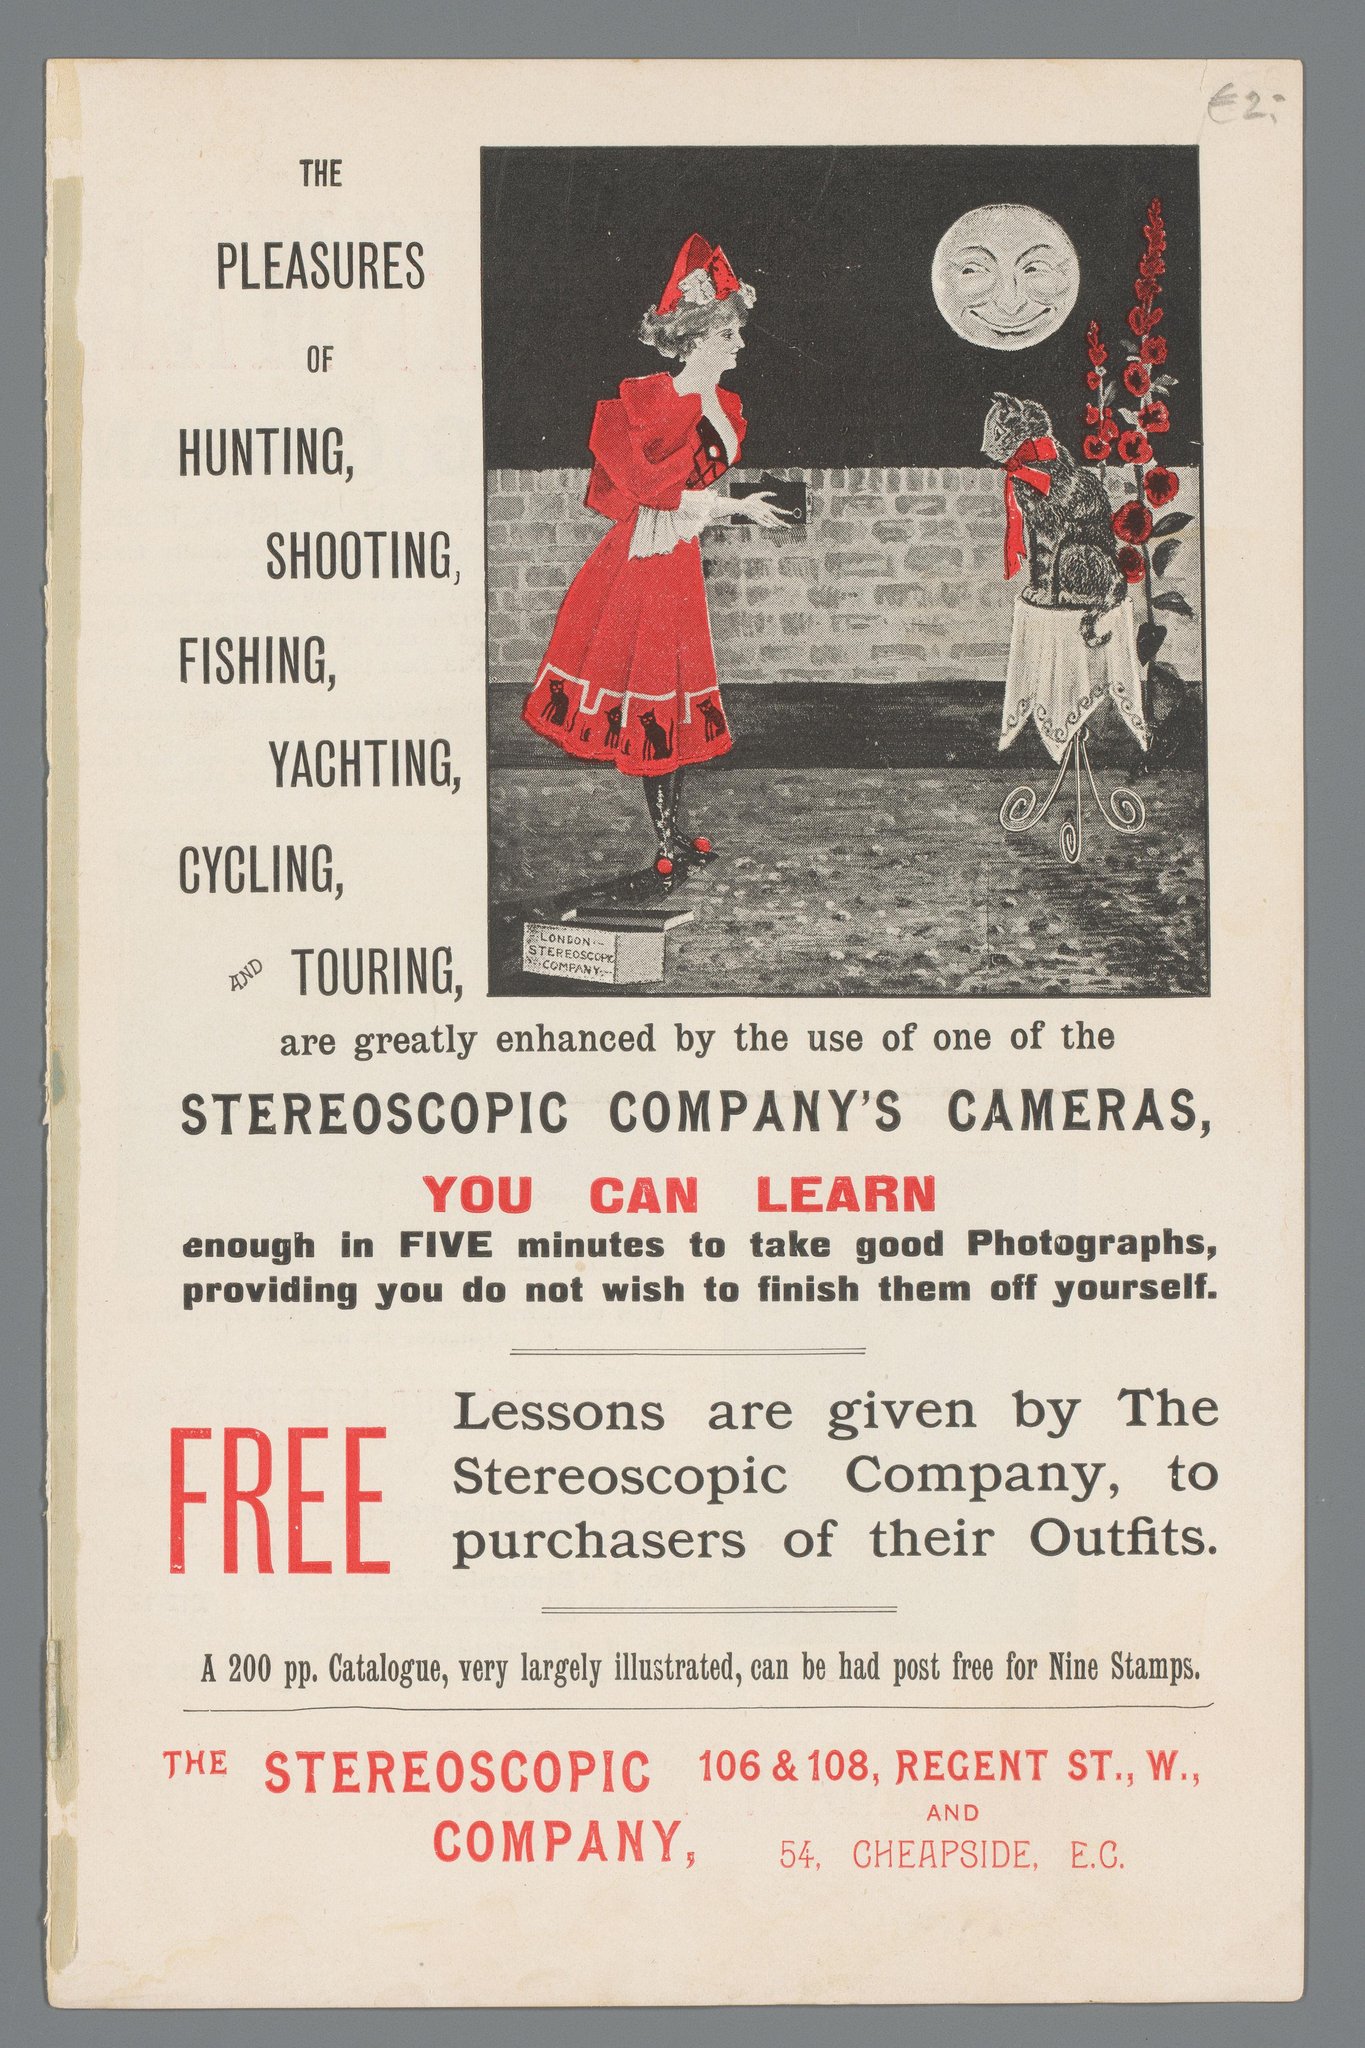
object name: document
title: Folder van de London Stereoscopic Company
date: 1881-1922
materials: paper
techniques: letterpress printing, lithograph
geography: london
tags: advertising, london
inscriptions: inscription: ‘THE/ PLEASURES/ OF/ HUNTING,/ SHOOTING,/ FISHING,/ YACHTING,/ CYCLING,/ AND TOURING,/ are greatly enhanced by the use of one of the/ STEREOSCOPIC COMPANY'S CAMERAS,/ YOU CAN LEARN/ enough in FIVE minutes to take good Photographs,/ providing you do not wish to finish them off yourself./ (...)’